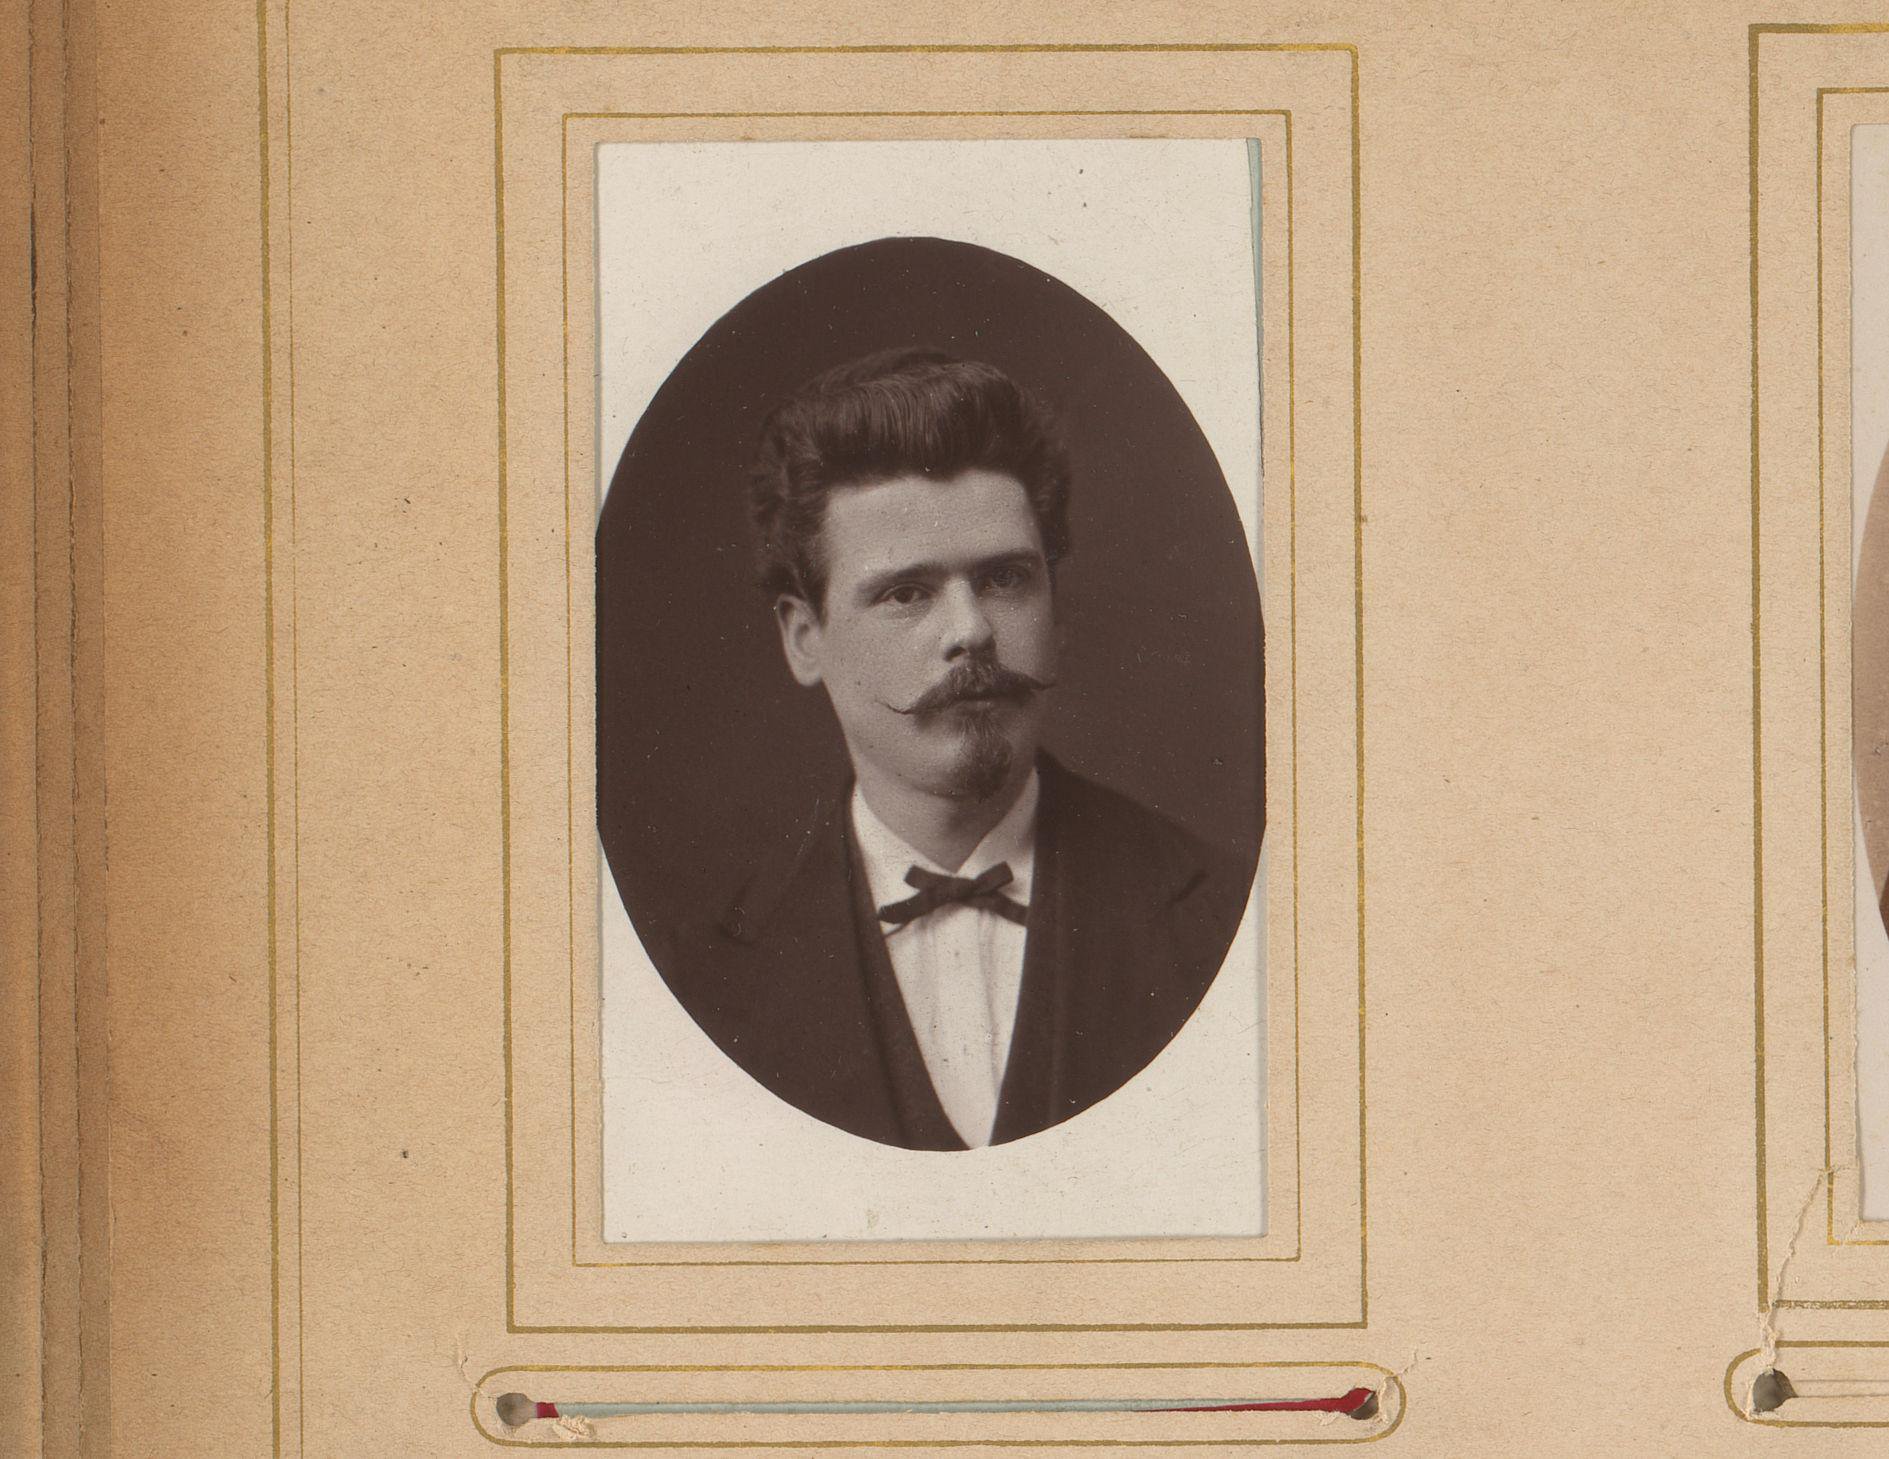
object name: carte de visite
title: Portret van een man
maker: georges raynaud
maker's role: fotograaf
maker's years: 1847-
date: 1870-1890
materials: cardboard, photographic support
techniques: collodion silver print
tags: adult man, historical persons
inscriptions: name: ‘Geroges Raynaud’